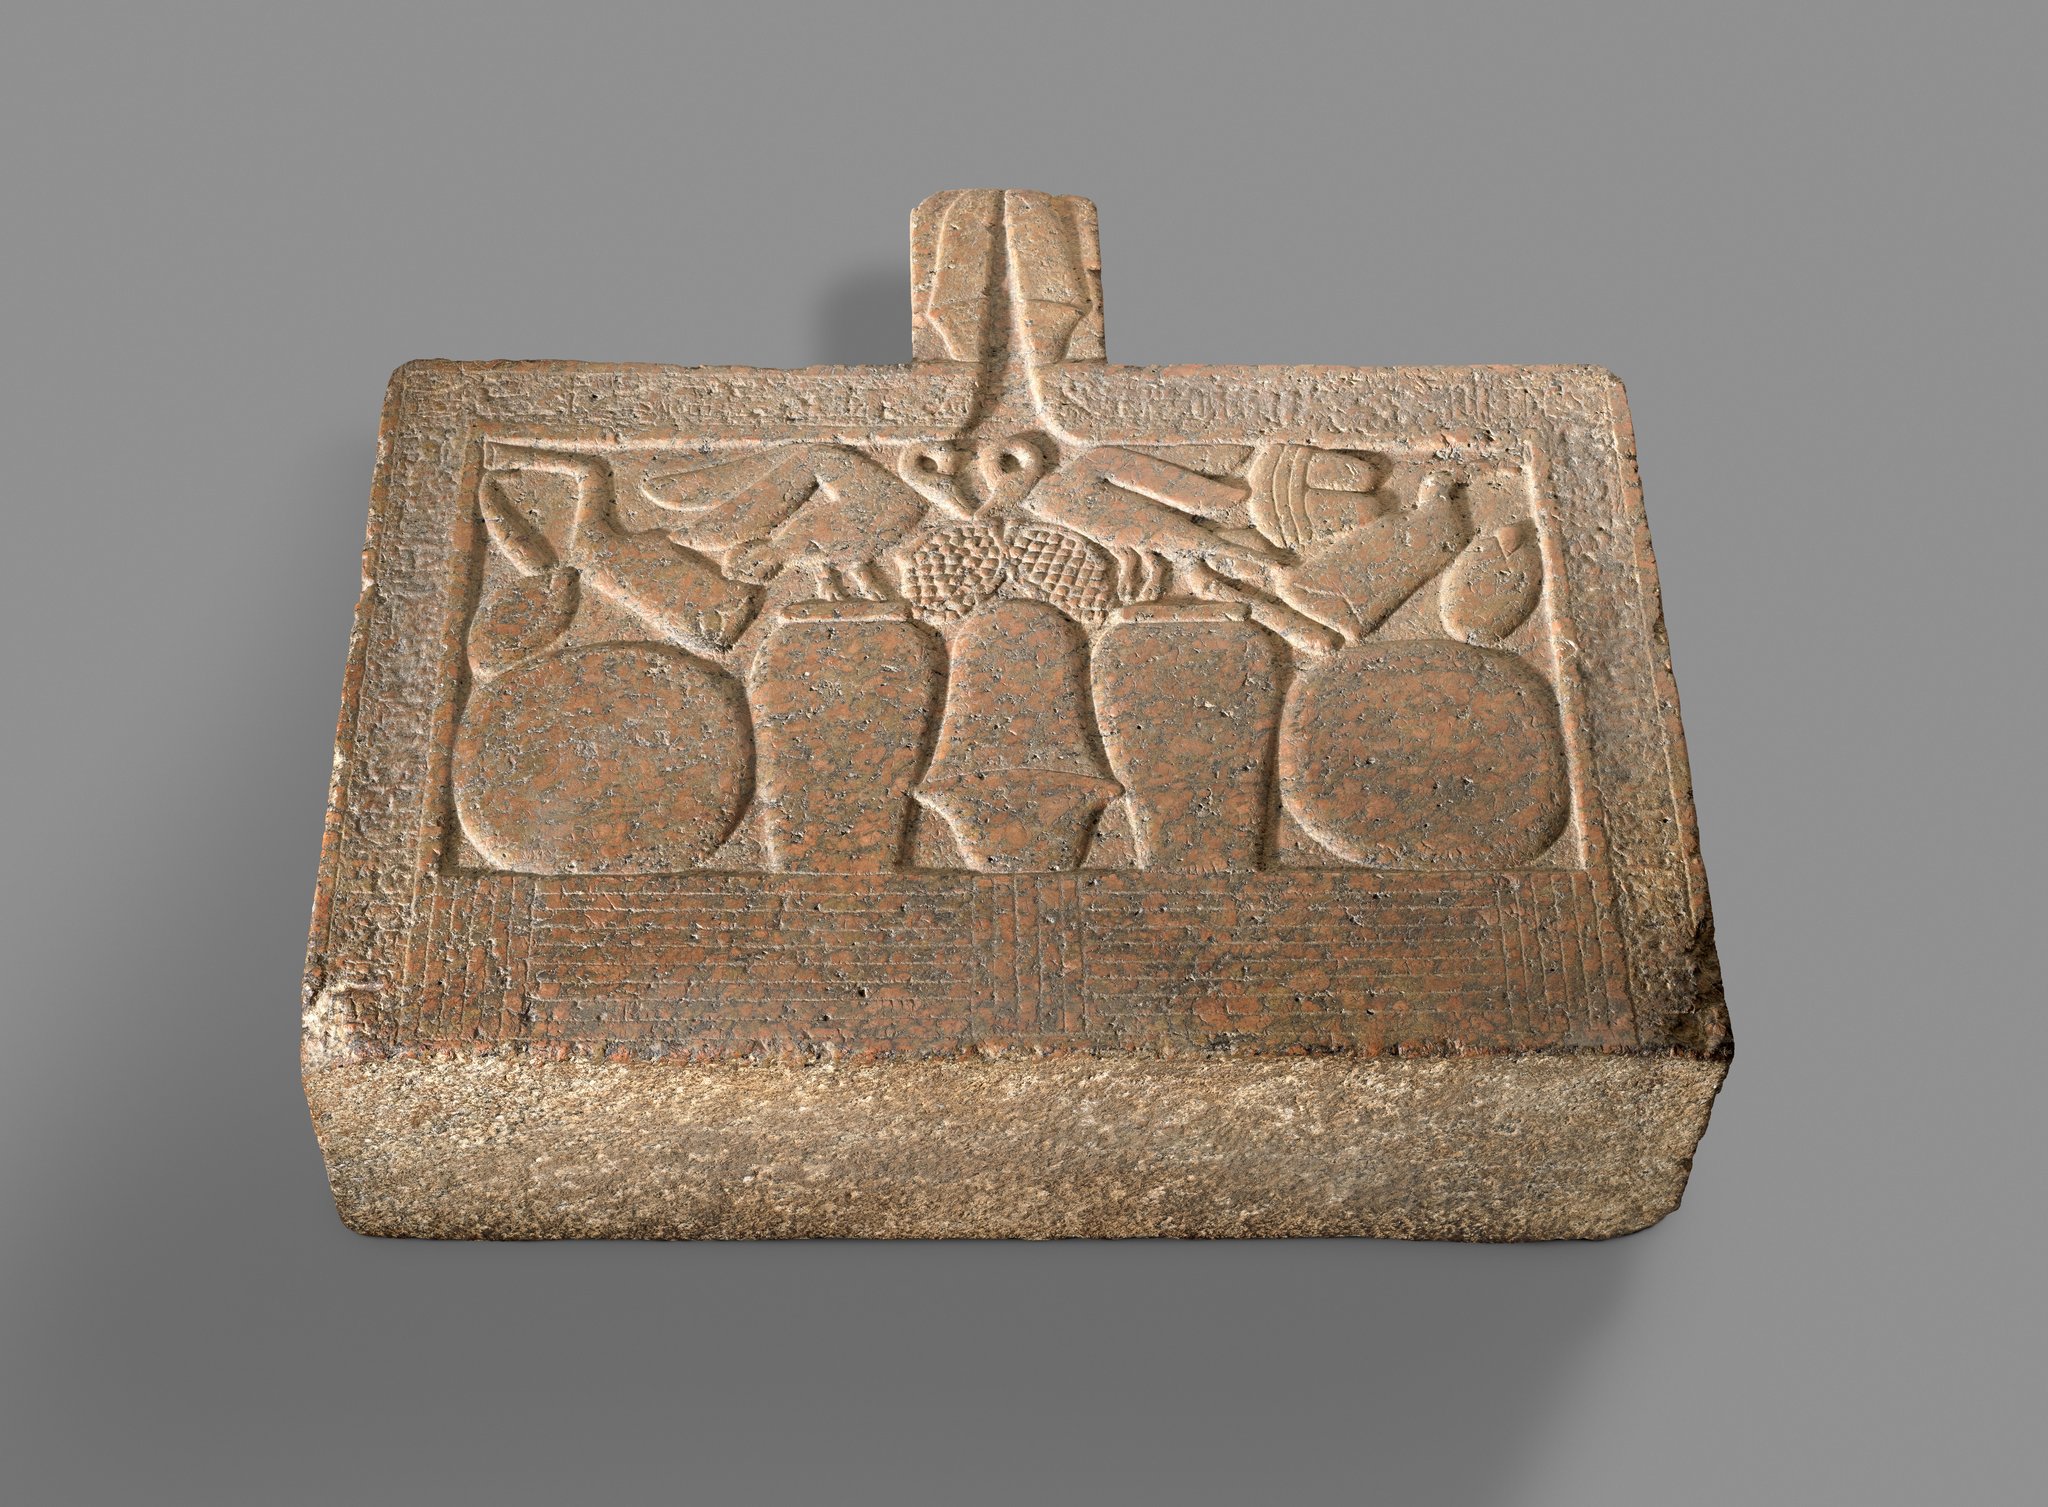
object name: offering table, pabasa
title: Offering table of Pabasa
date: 664-610 BCE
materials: granite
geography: egypt